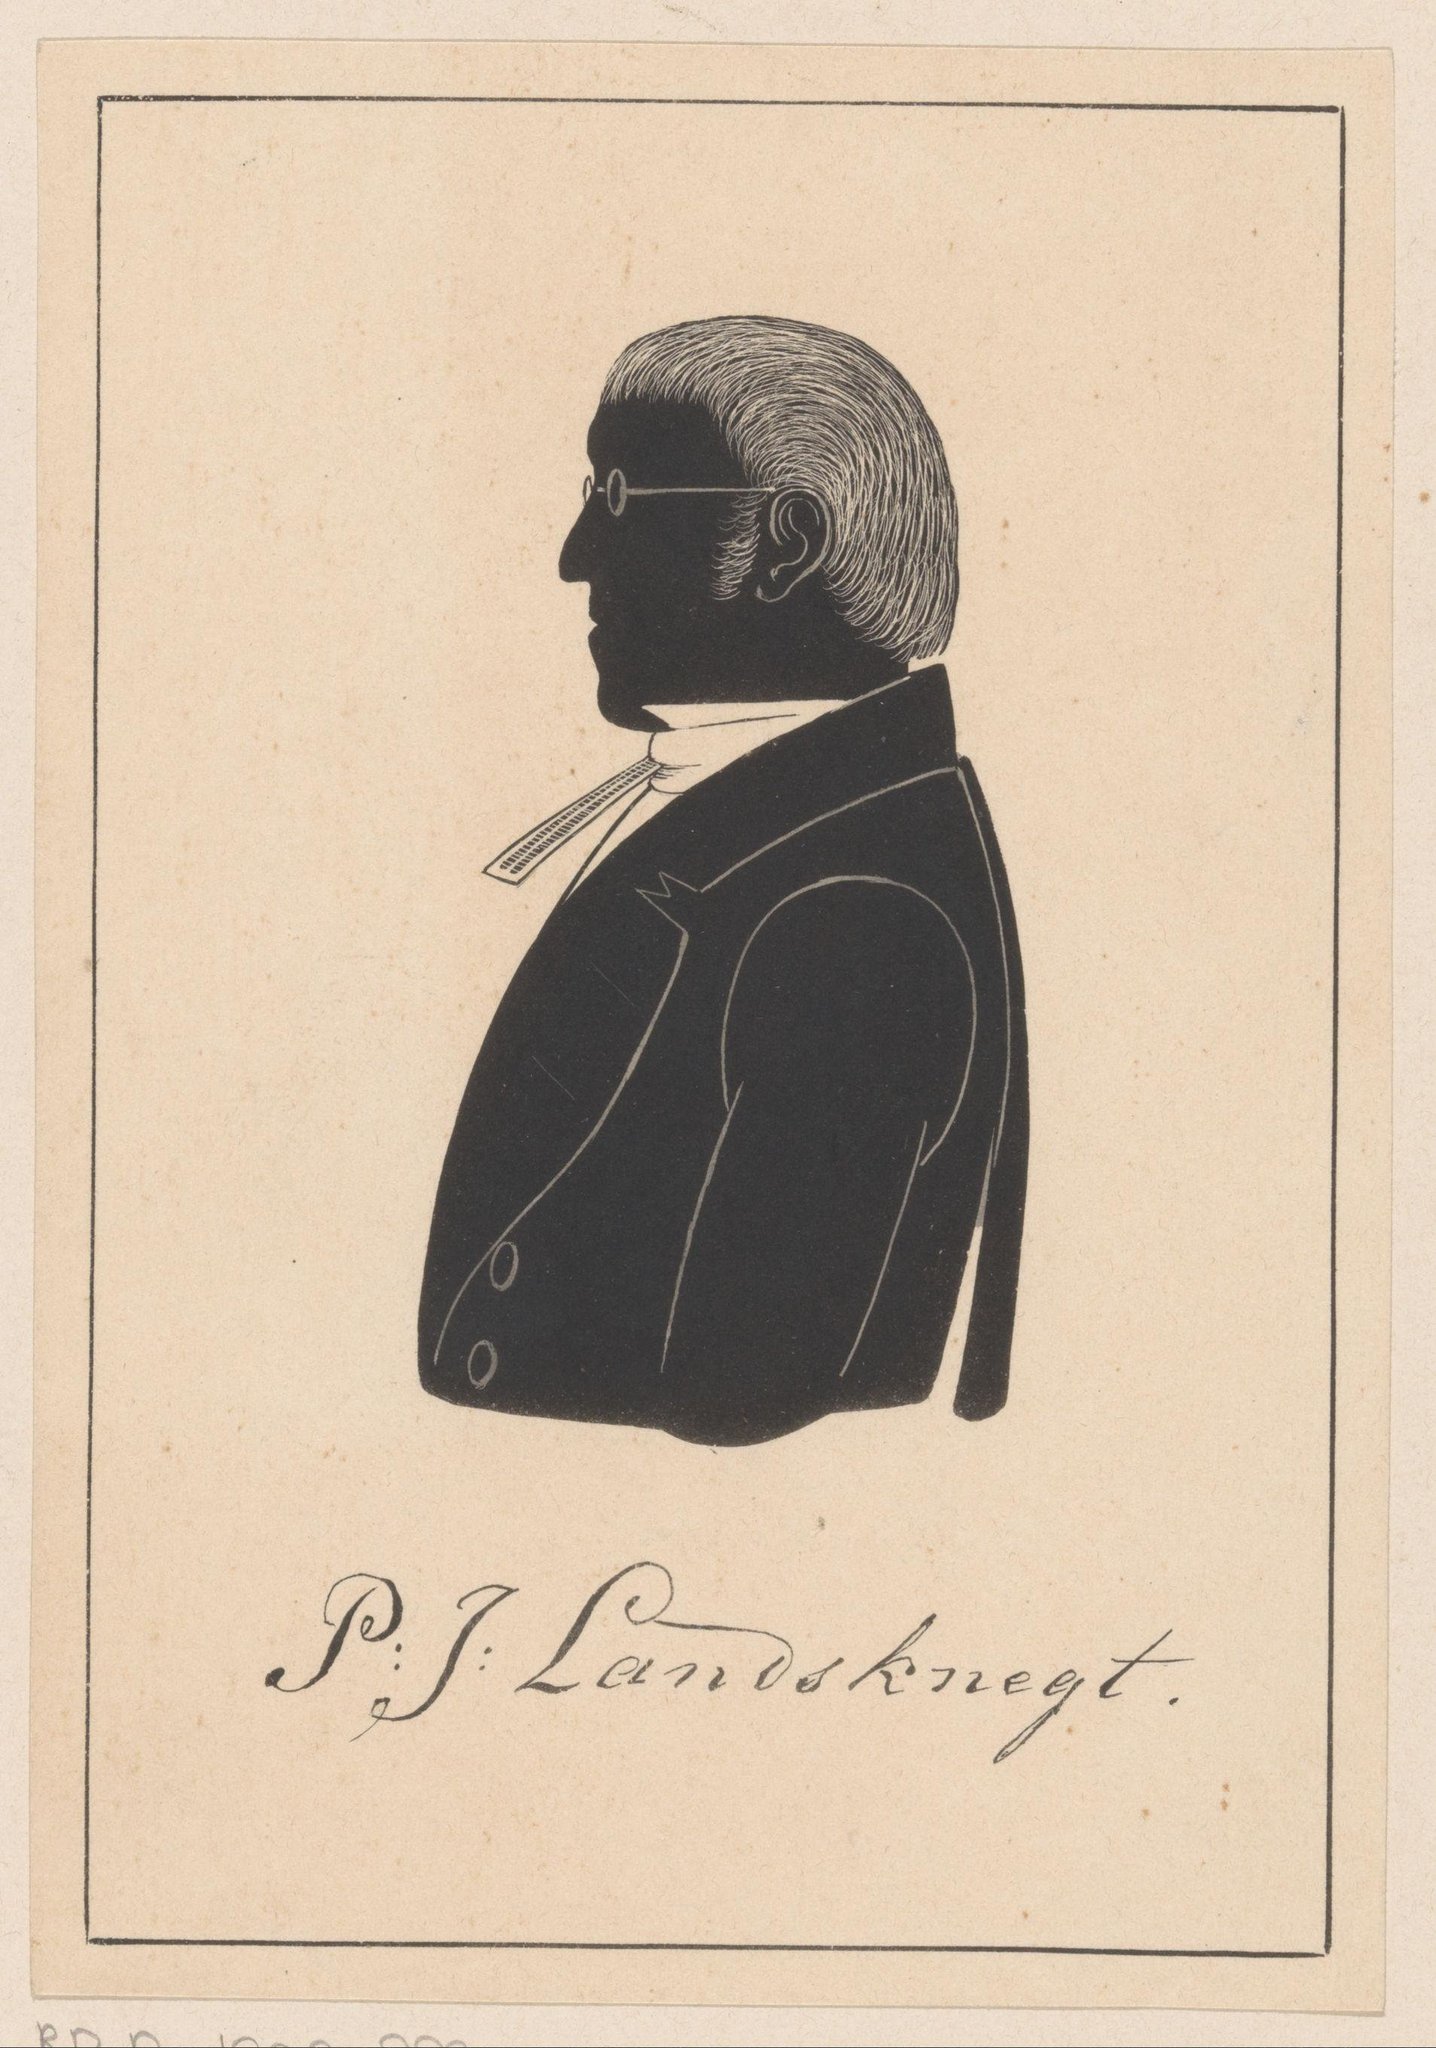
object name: print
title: Silhouetportret van P.J. Landsknegt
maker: pieter barbiers (iv)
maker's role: painter, print maker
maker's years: 1798-1848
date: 1809-1848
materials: paper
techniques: hand coloring, lithograph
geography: netherlands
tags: historical persons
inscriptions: collector's mark: Lugt 2228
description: Onder het portret de signatuur van de geportretteerde.